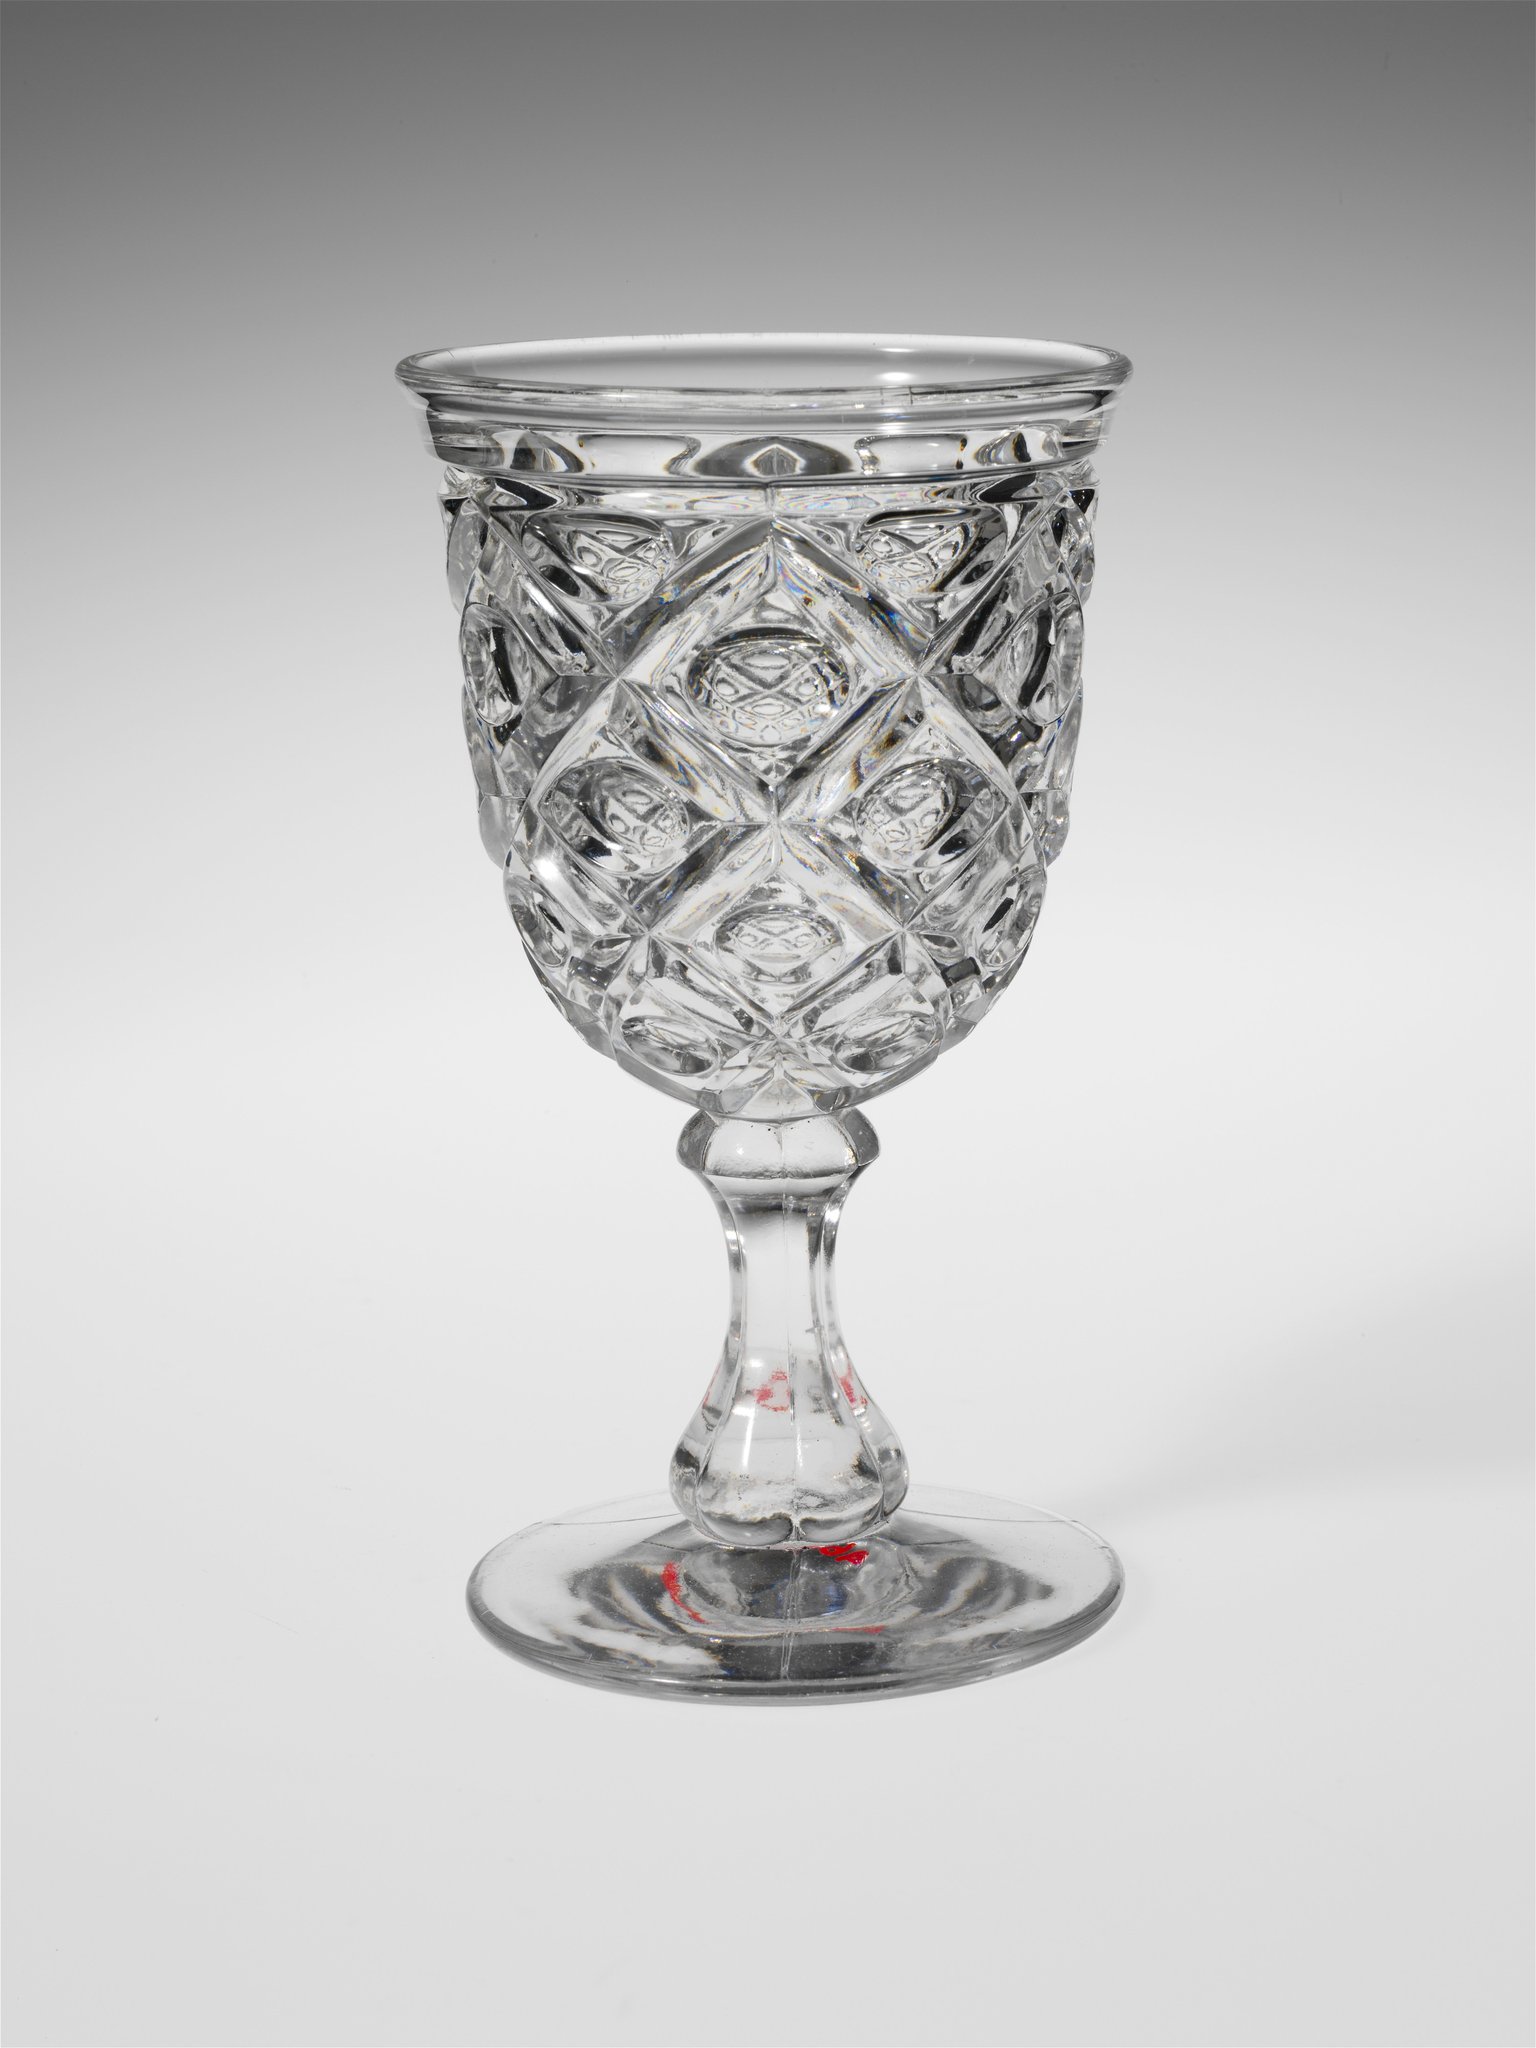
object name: goblet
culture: american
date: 1850-1860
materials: diamond, glass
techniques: pressed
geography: united states